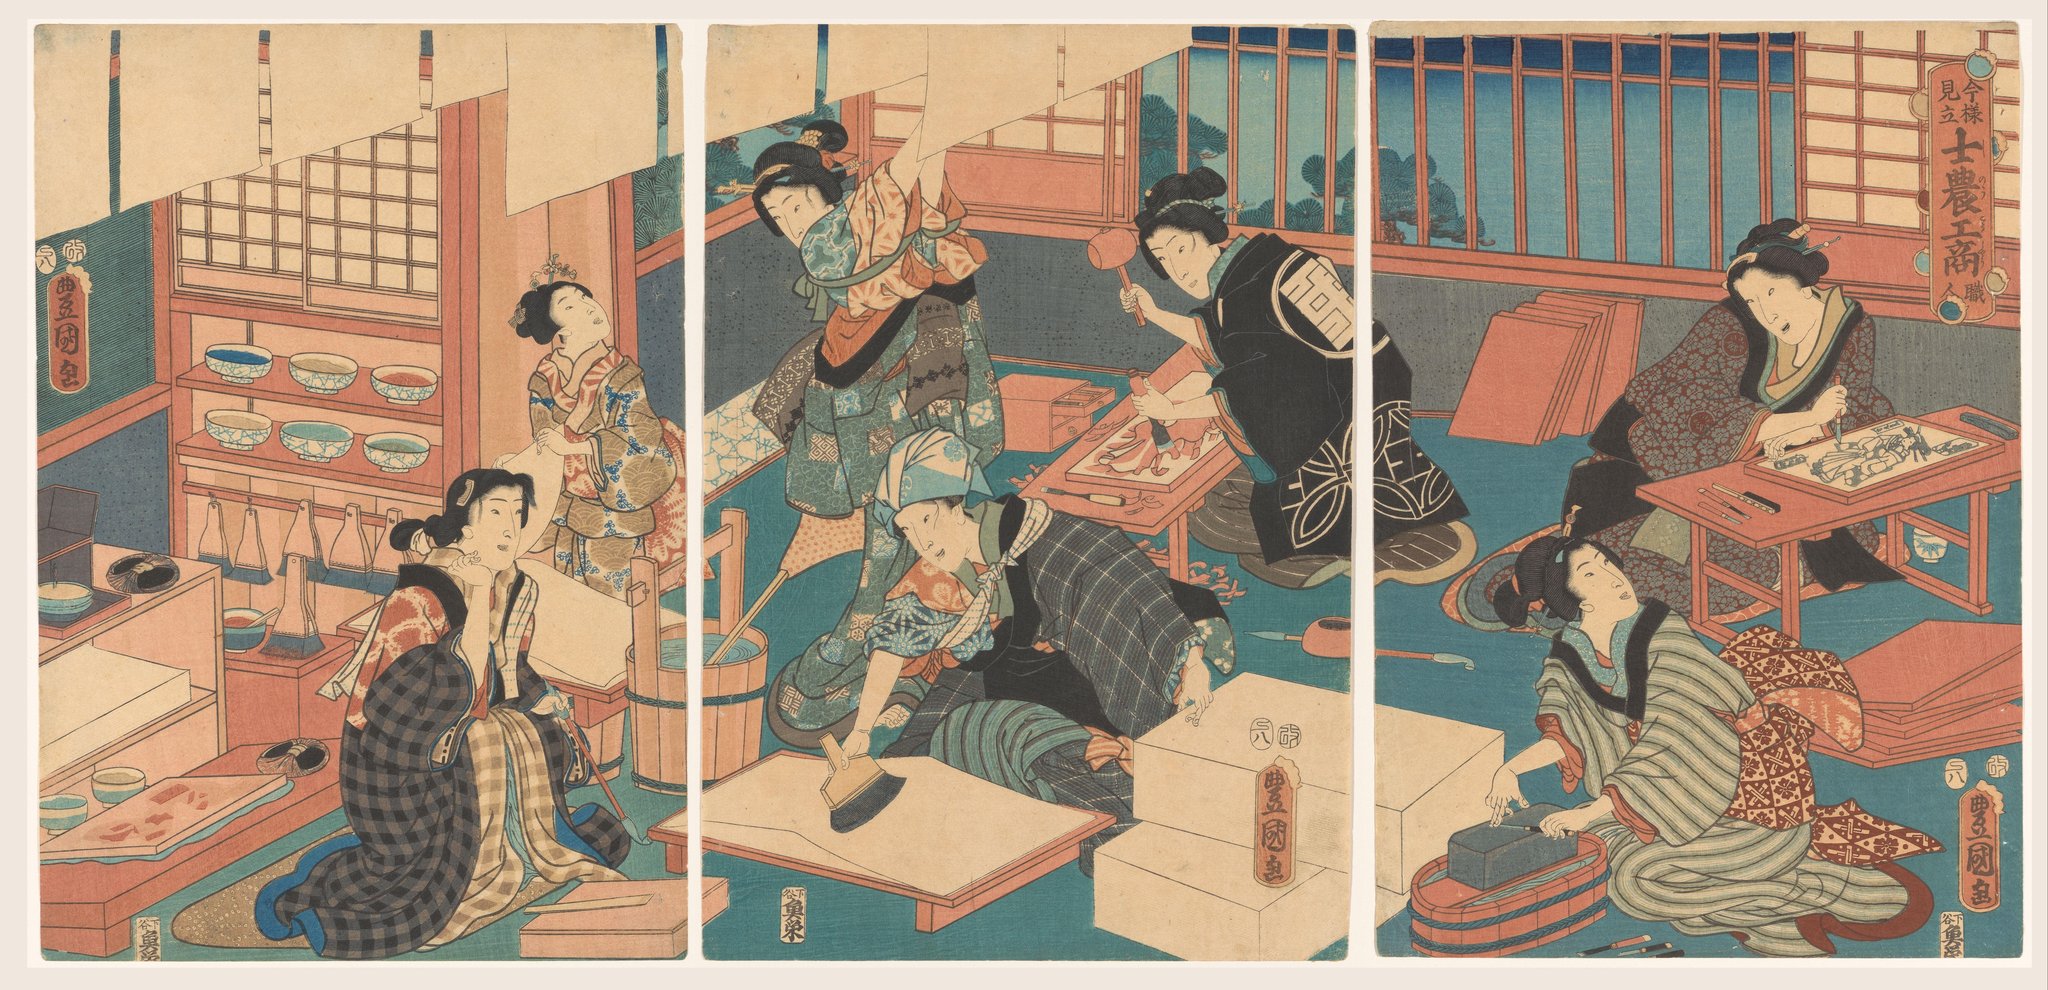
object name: print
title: Vrouwen maken prenten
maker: utagawa kunisada (i)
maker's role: print maker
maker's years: 1786-1865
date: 1857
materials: paper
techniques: blind stamped, woodcut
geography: japan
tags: tools, implements of graphic artist, artist at work, in his workshop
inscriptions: collector's mark: Lugt 2228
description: Dit object is omwille van een betere presentatie virtueel samengevoegd, maar bestaat fysiek uit losse onderdelen.